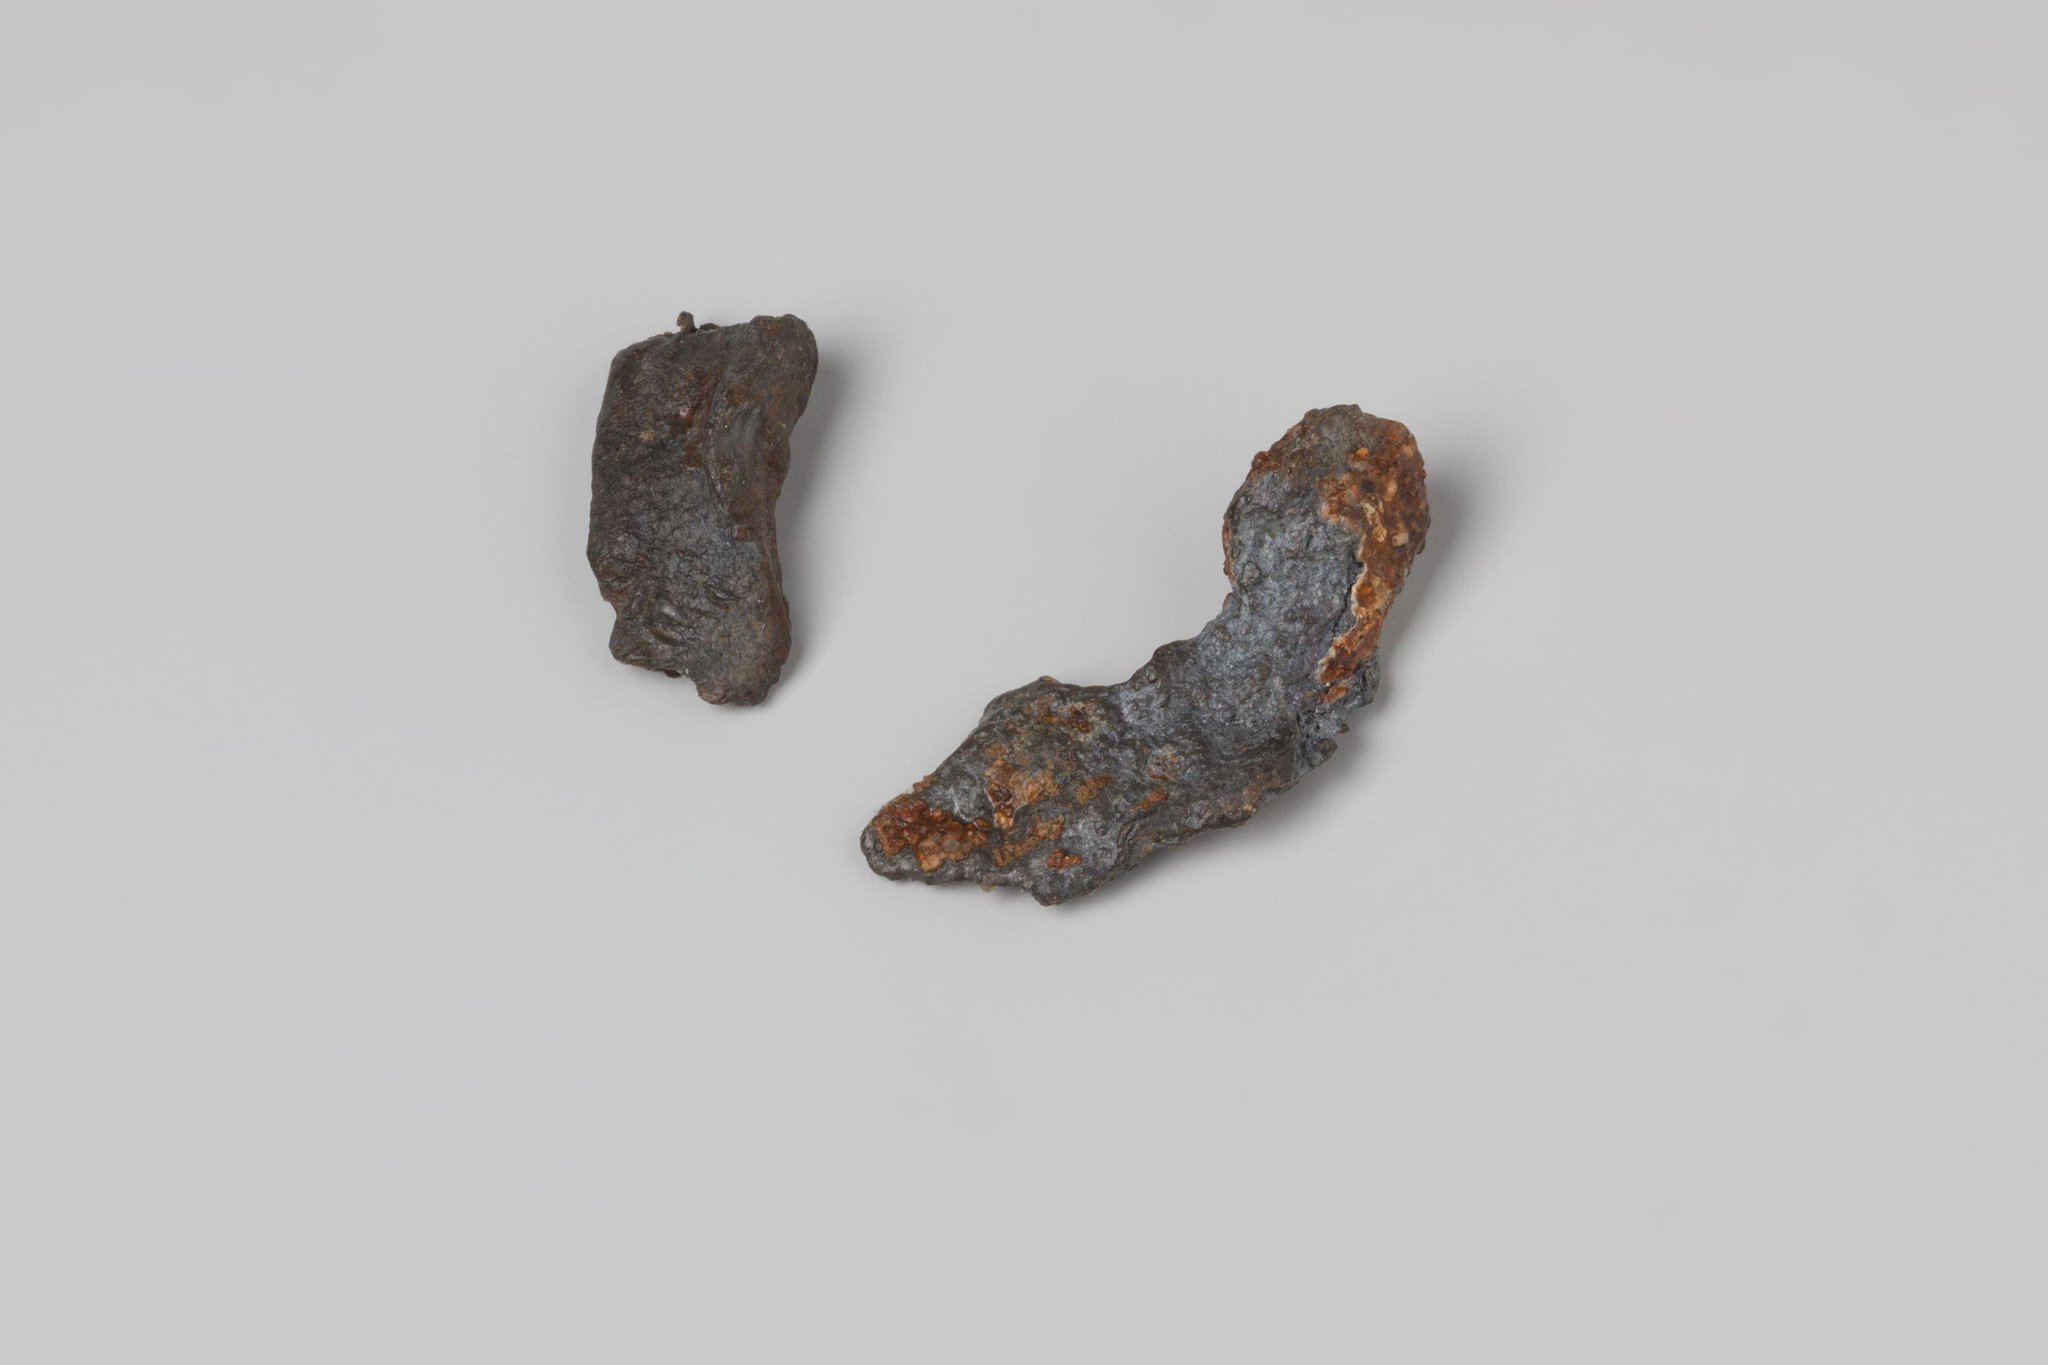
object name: fragment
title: Fragmenten lood uit het wrak van de Oost-Indiëvaarder Hollandia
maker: Anonymous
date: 1700-1743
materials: lead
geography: netherlands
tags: verenigde oostindische compagnie, hollandia (schip), annet